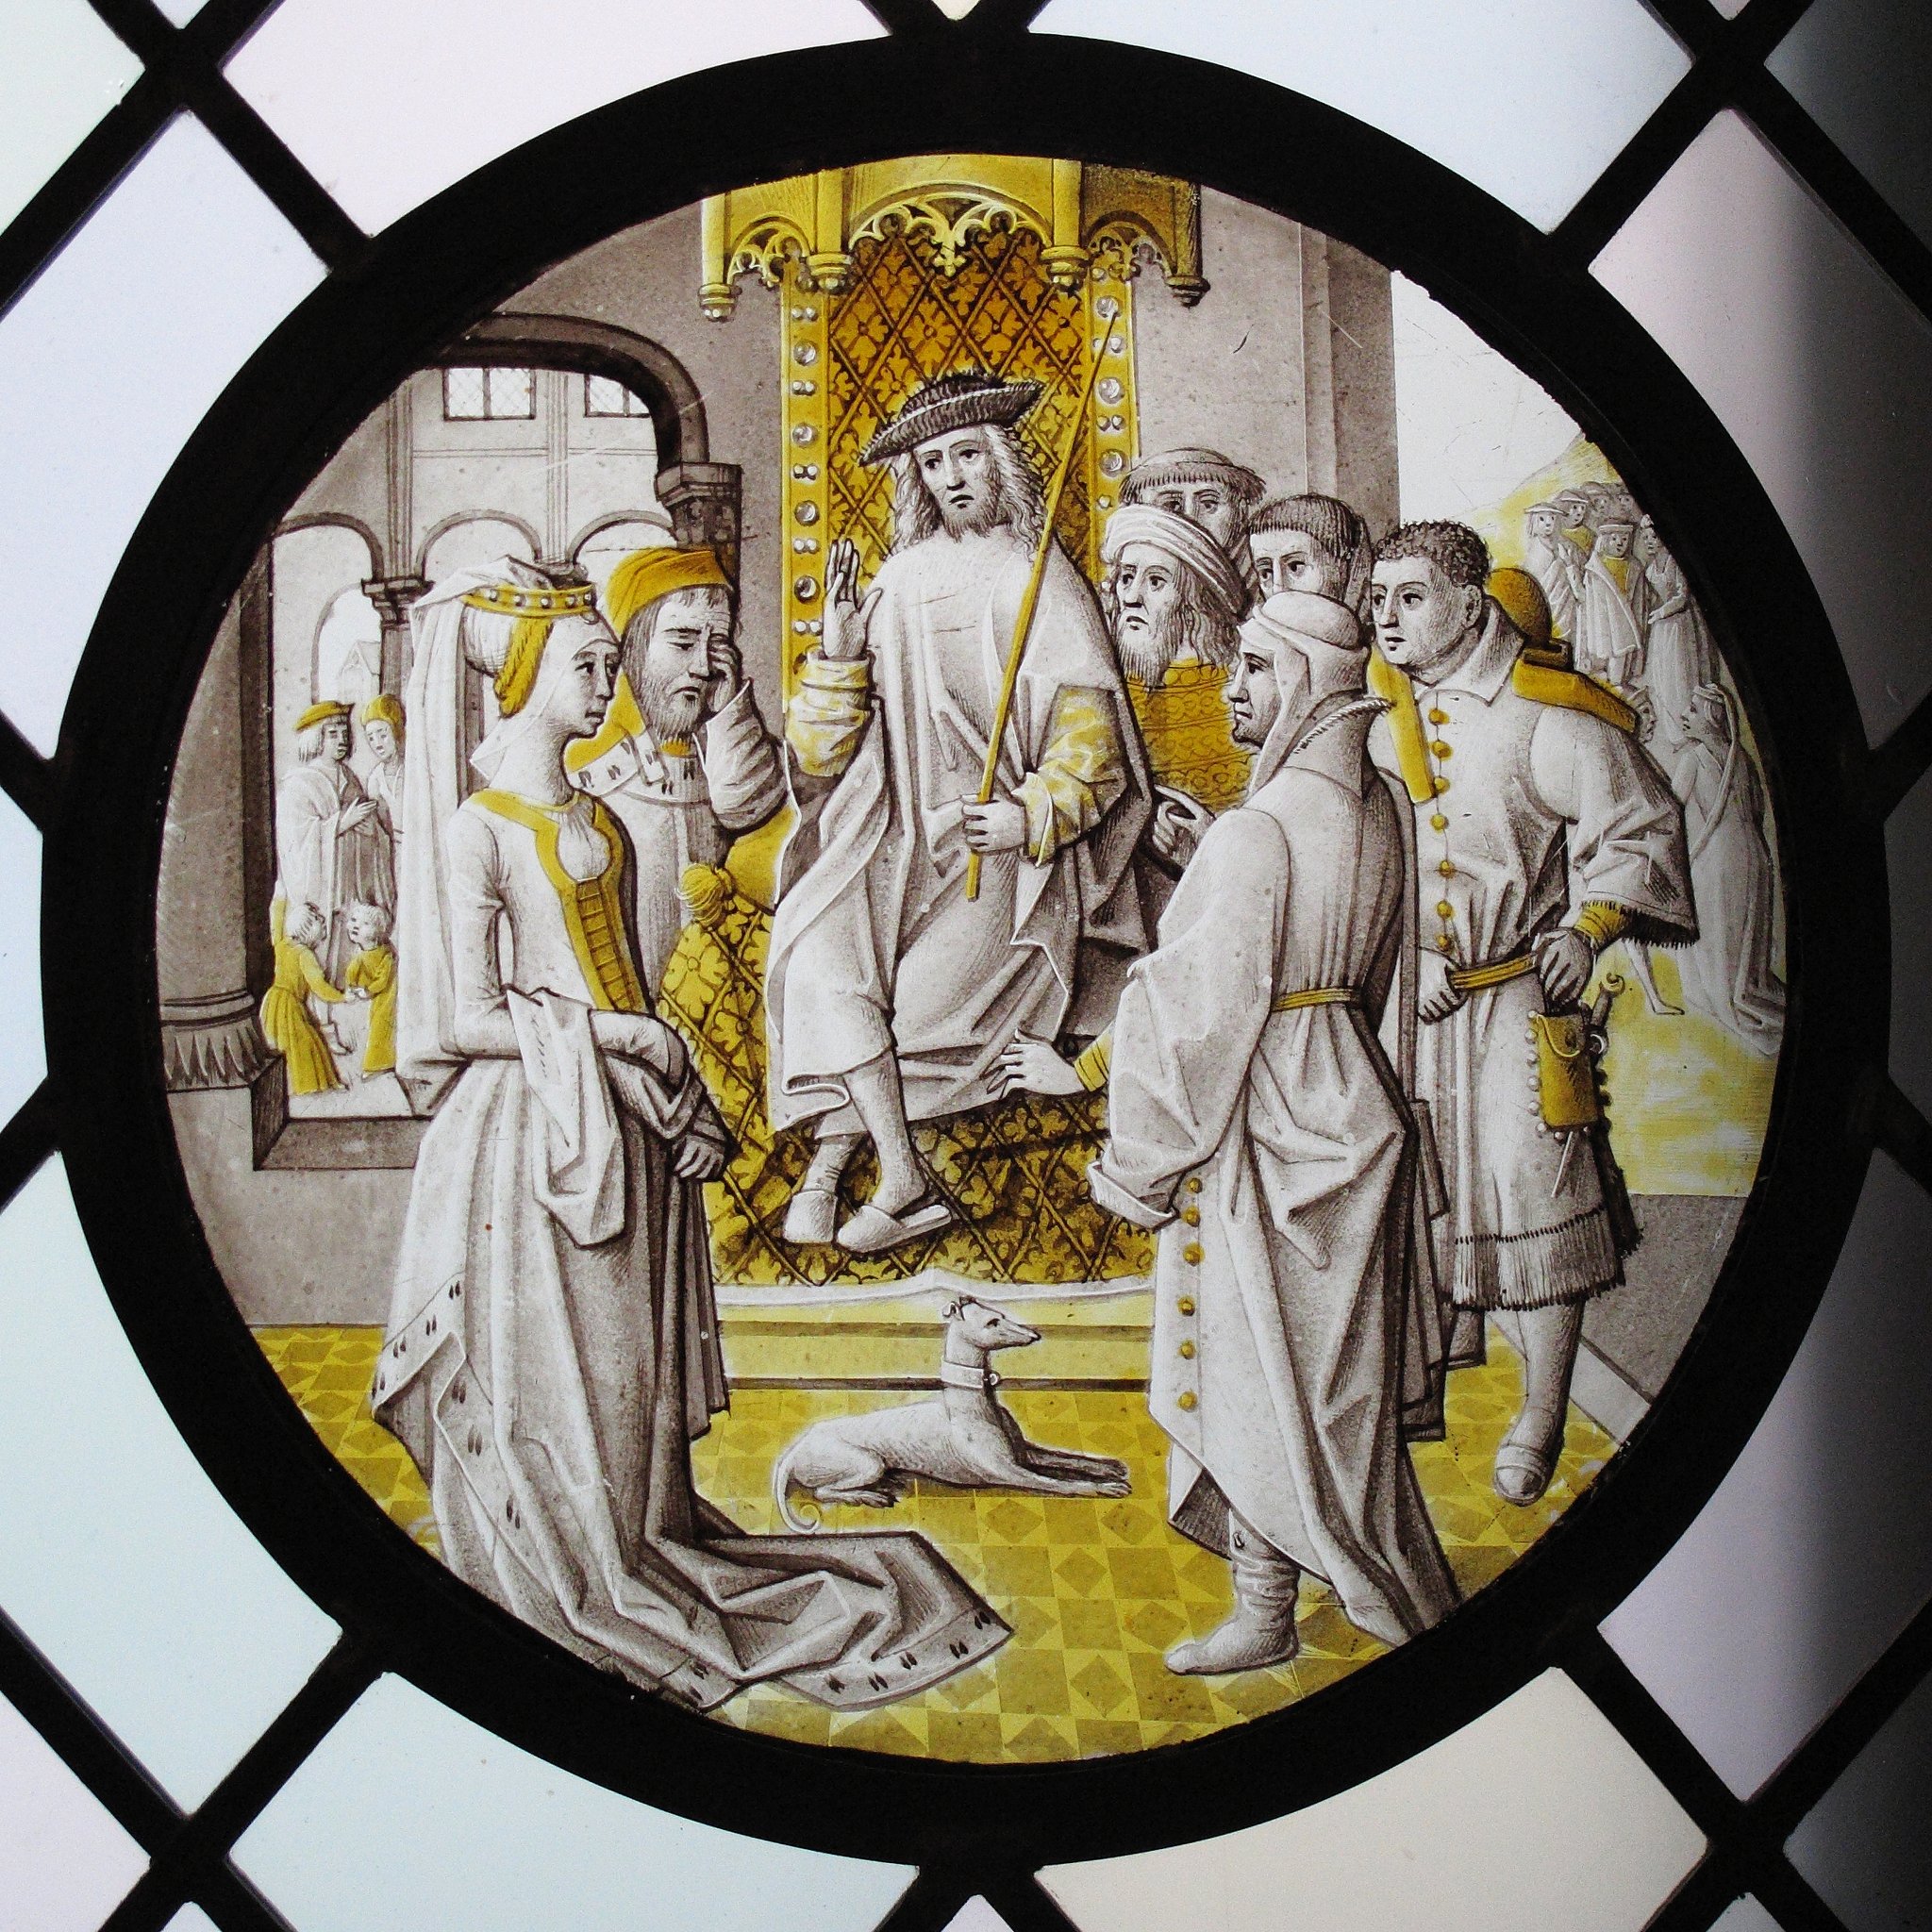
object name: roundel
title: Roundel with Susanna In Judgement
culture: south netherlandish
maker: after master of the jospeh panels, jacob van lathem?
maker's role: artist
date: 1510-1520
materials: glass, paint, pigment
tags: men,women,dogs